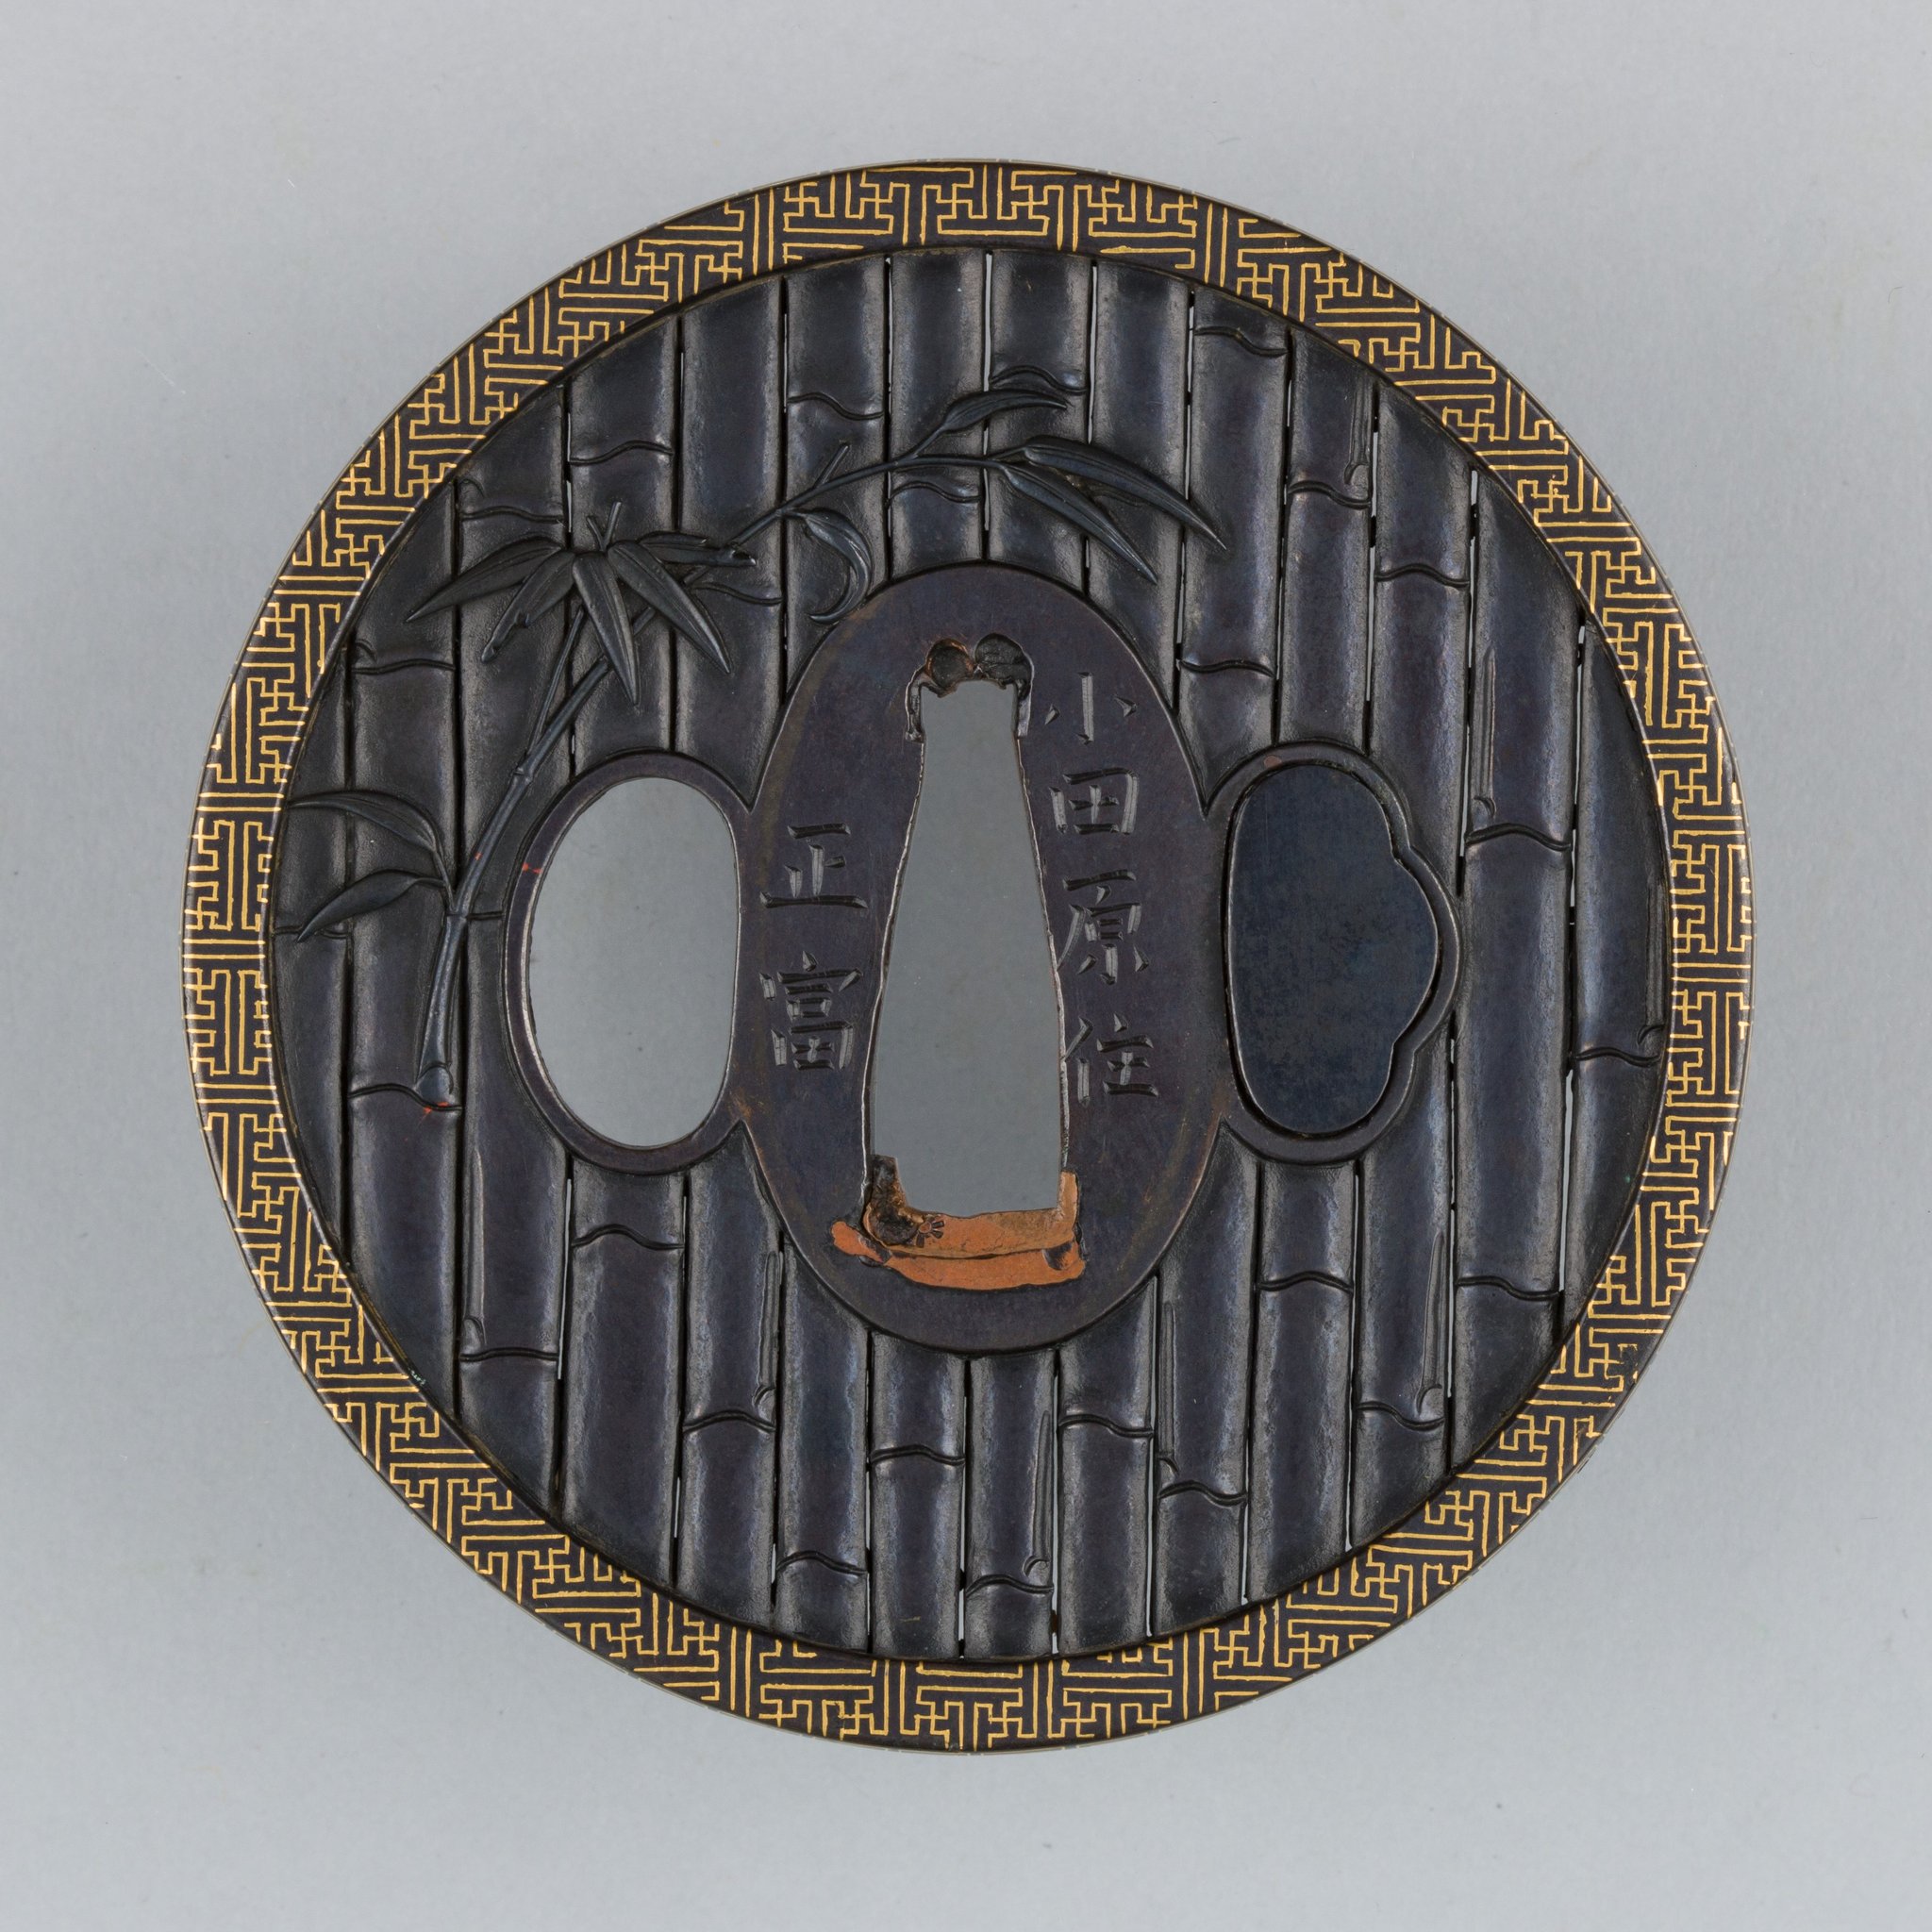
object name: sword guard tsuba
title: Sword Guard (Tsuba)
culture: japanese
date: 1701-1733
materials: copper, gold alloy, gold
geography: japan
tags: bamboo